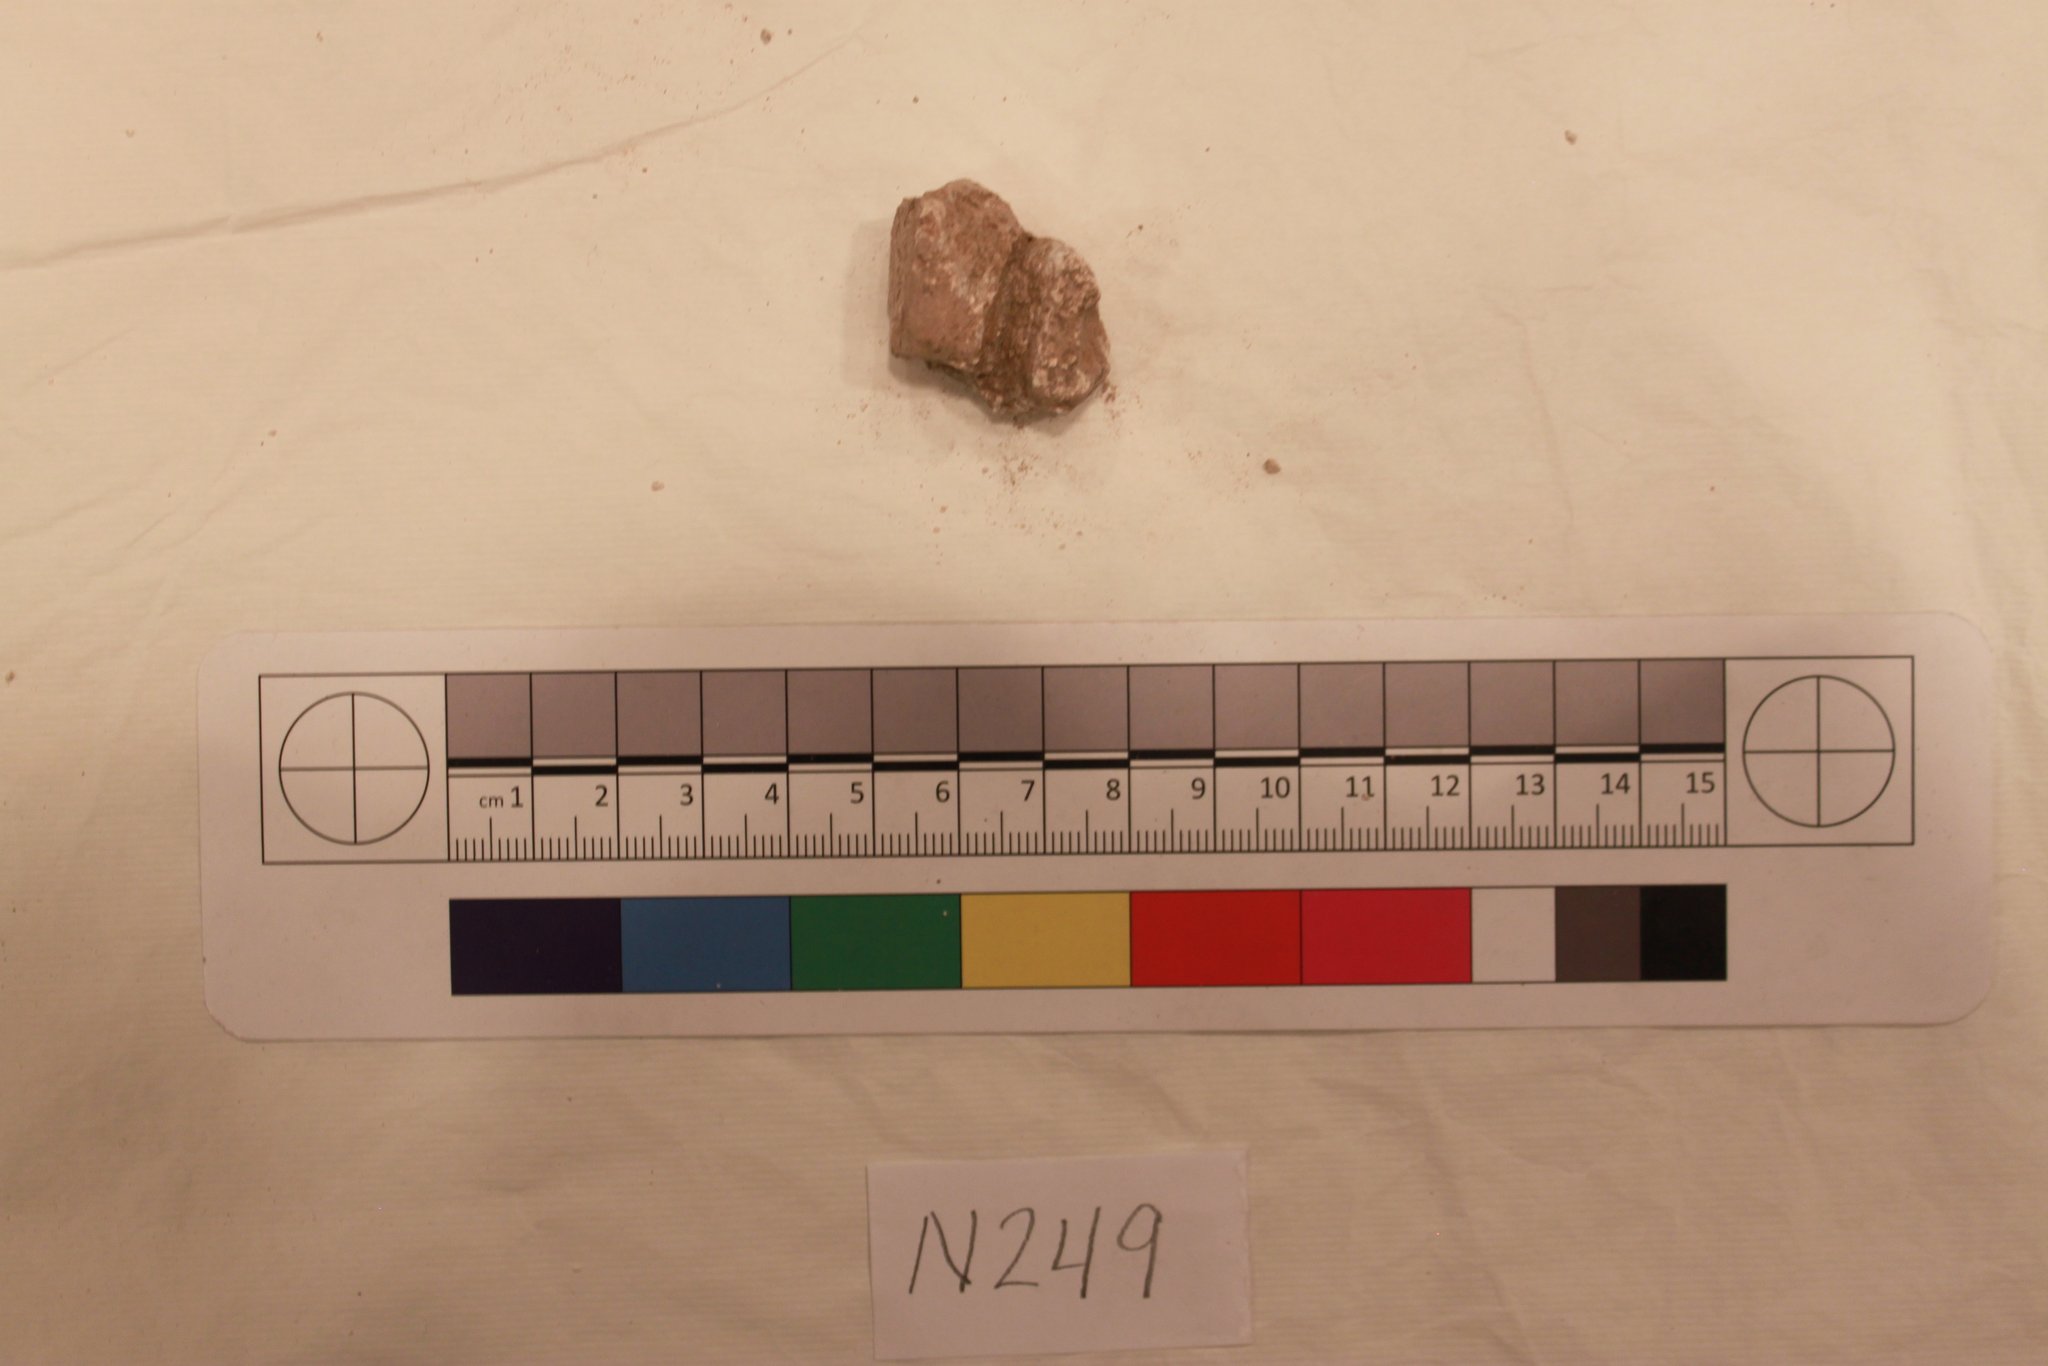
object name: fragment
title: Stucco Fragment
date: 701-1200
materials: plaster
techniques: carving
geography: iran